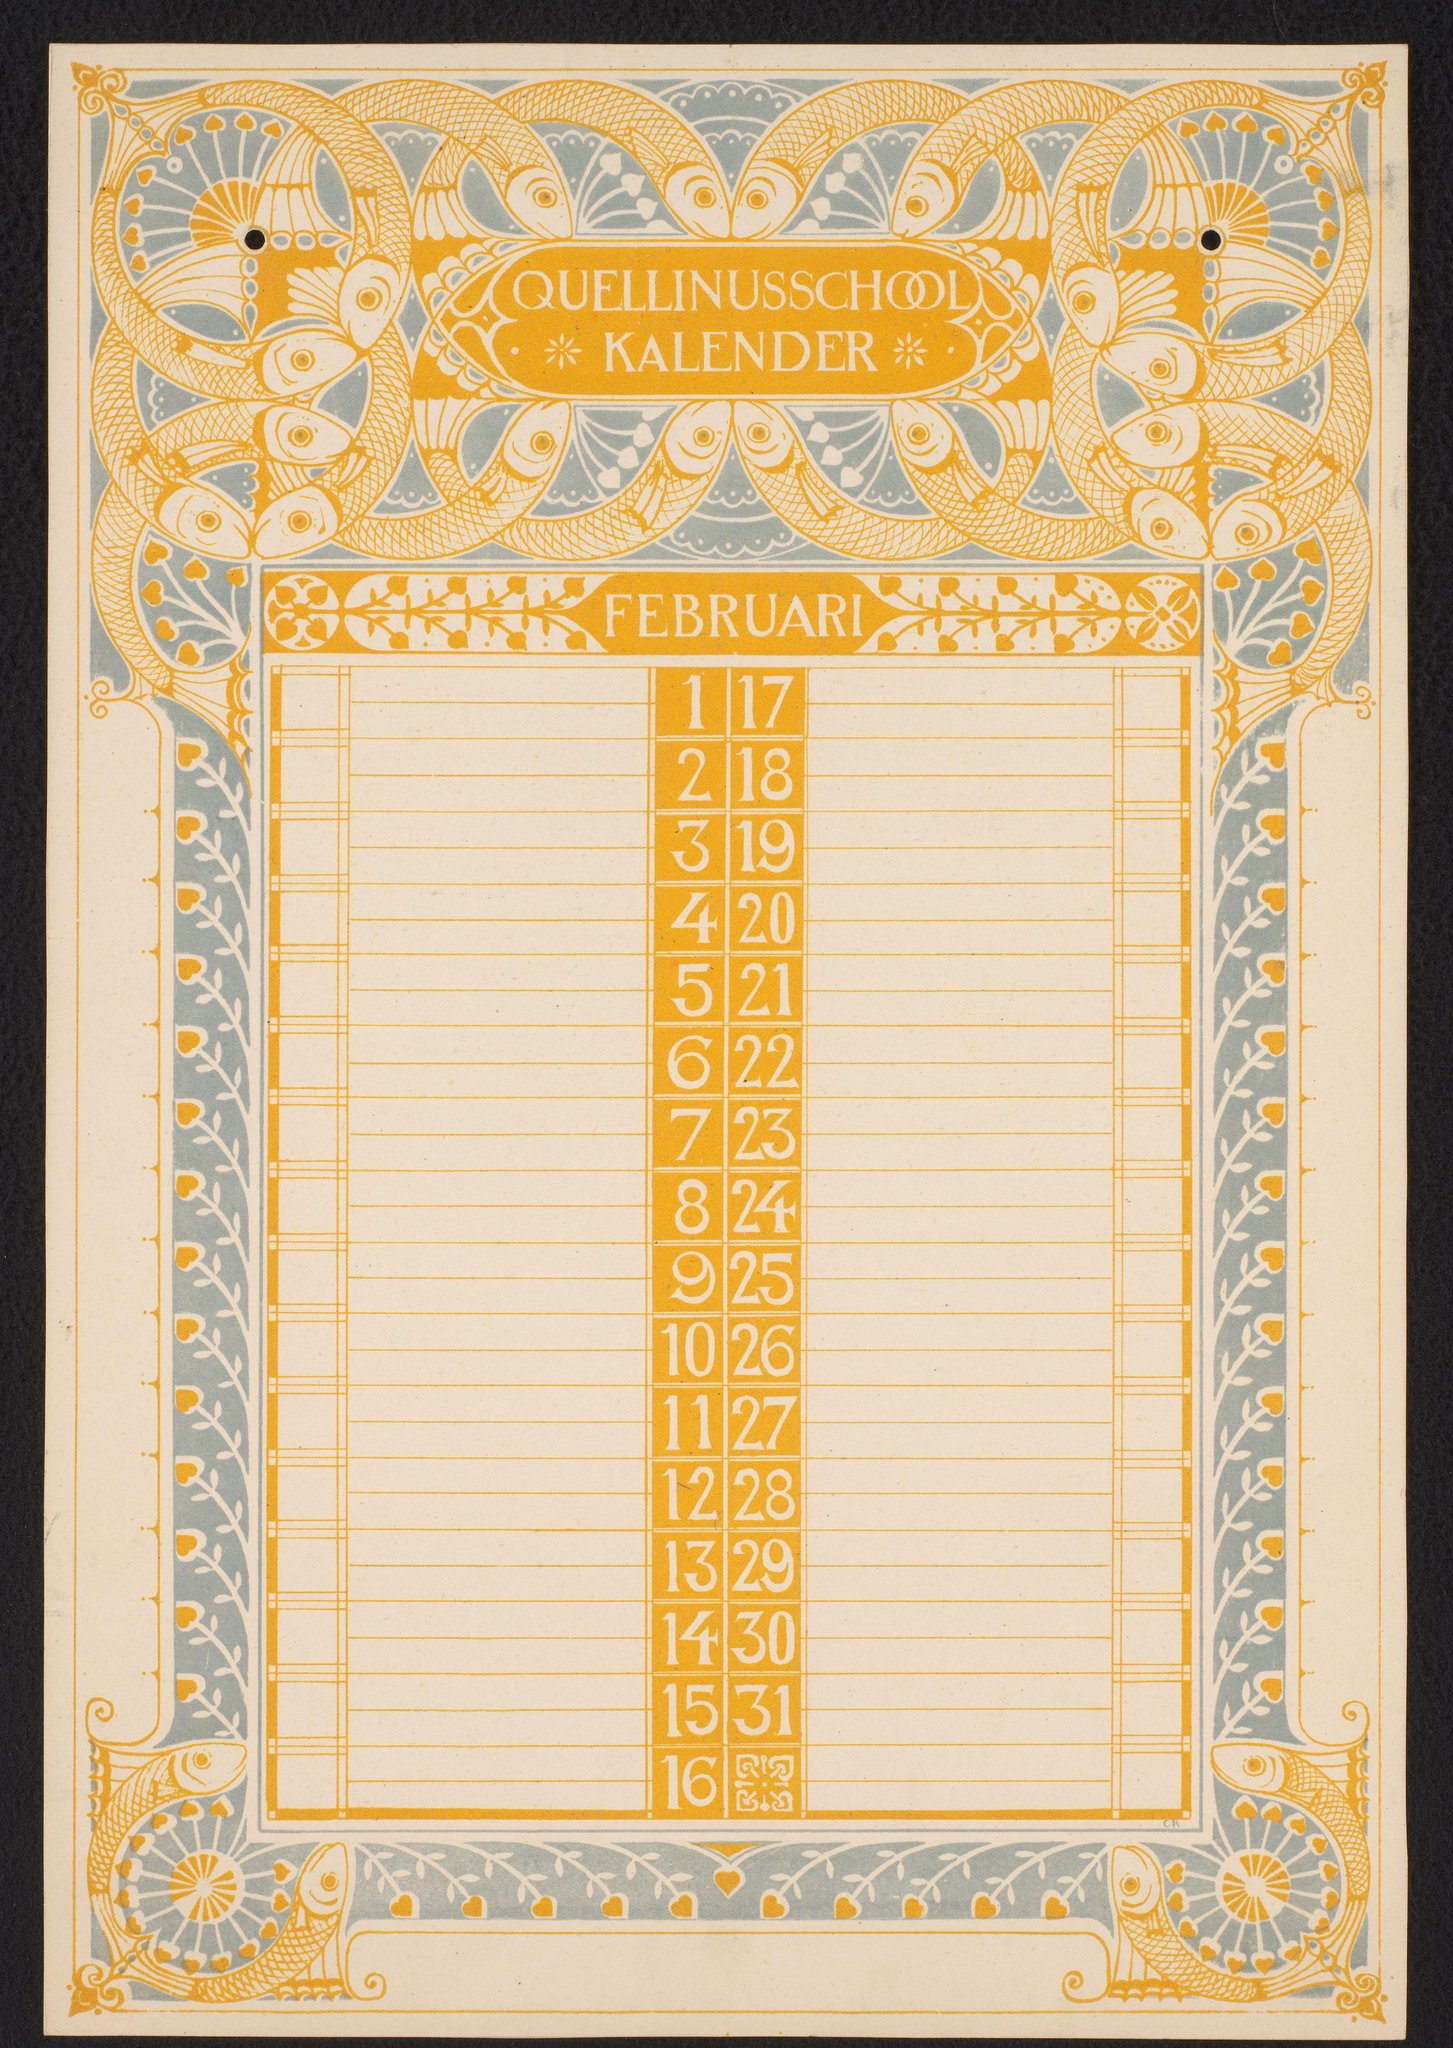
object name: calendar leaf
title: Kalenderblad voor februari, van een kalender van Kunstnijverheidsschool Quellinus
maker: Anonymous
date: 1885-1925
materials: paper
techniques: lithograph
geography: amsterdam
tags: ornaments ~ art, calendar, almanac, fishes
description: Bij gebrek aan gegevens over de vervaardiger is voor de bepaling van de rechten van dit object gebruik gemaakt van de vervaardigingsdatum.